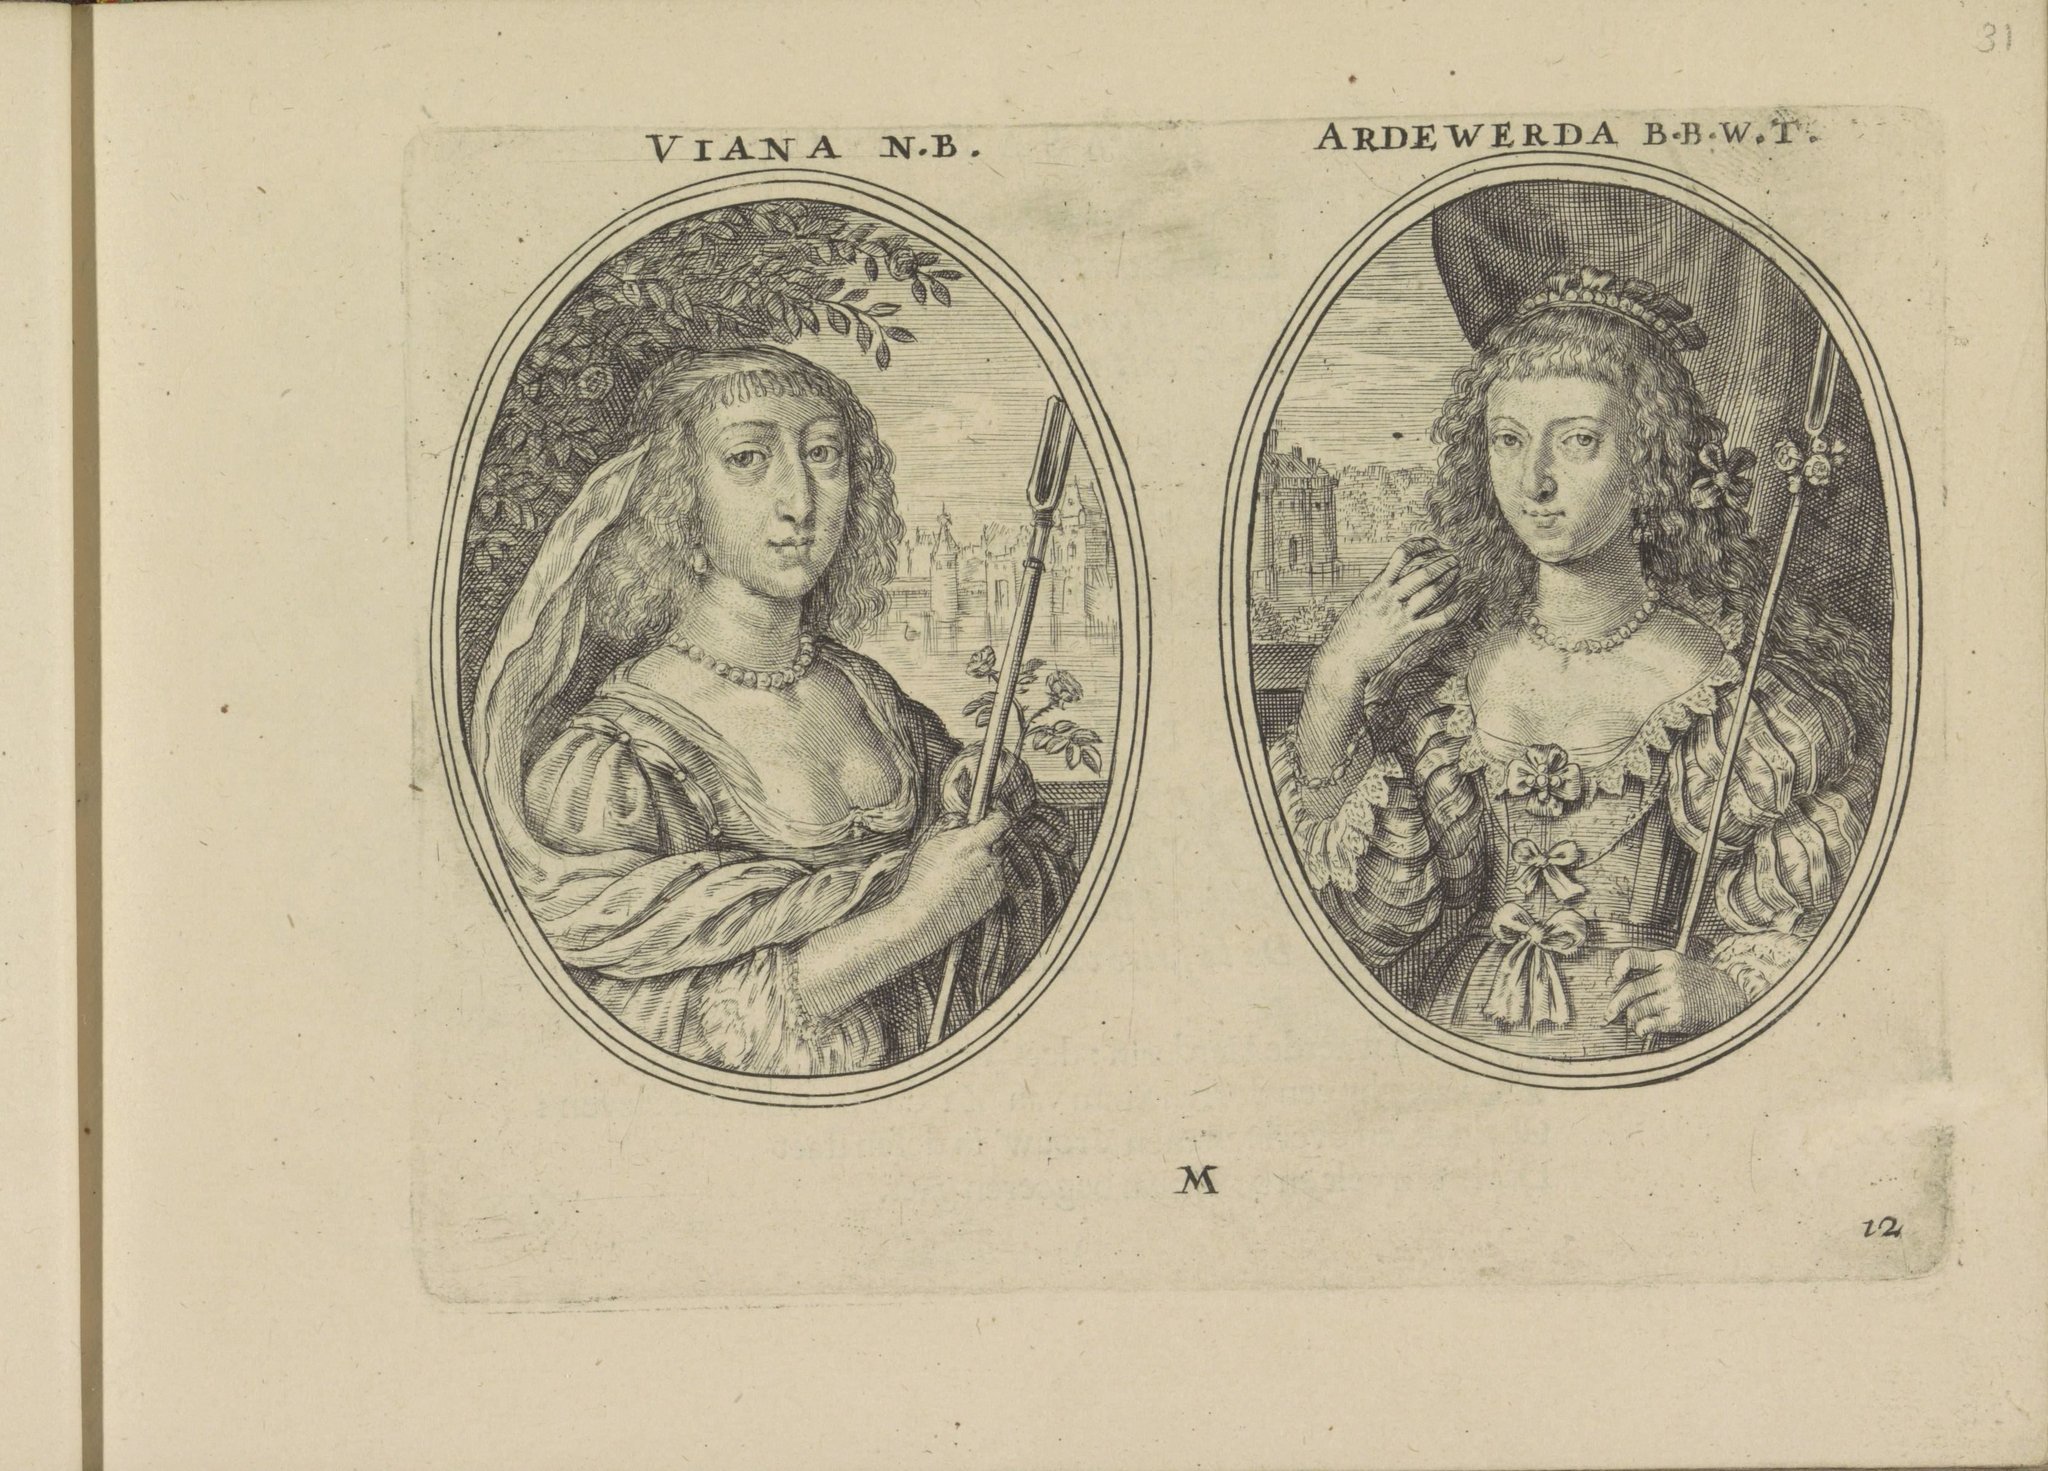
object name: print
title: Portretten van Louise van Solms en een onbekende hooggeplaatste vrouw, beiden als herderin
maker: crispijn van de passe (ii)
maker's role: draughtsman, print maker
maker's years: 1594-1670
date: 1640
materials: paper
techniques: engraving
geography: amsterdam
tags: female sex; woman, shepherd's crook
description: Twee voorstellingen op een albumblad. Links het portret van Louise van Solms, gravin van Vianen, als Viana N.B. Rechts een onbekende hoogeplaatste dame als Ardewerda B.B.W.T. De vrouwen hebben een herdersstaf in de hand. Op de achtergrond van beide voorstellingen een kasteel. Onderaan genummerd: M en 12. Het blad maakt deel uit van een album.